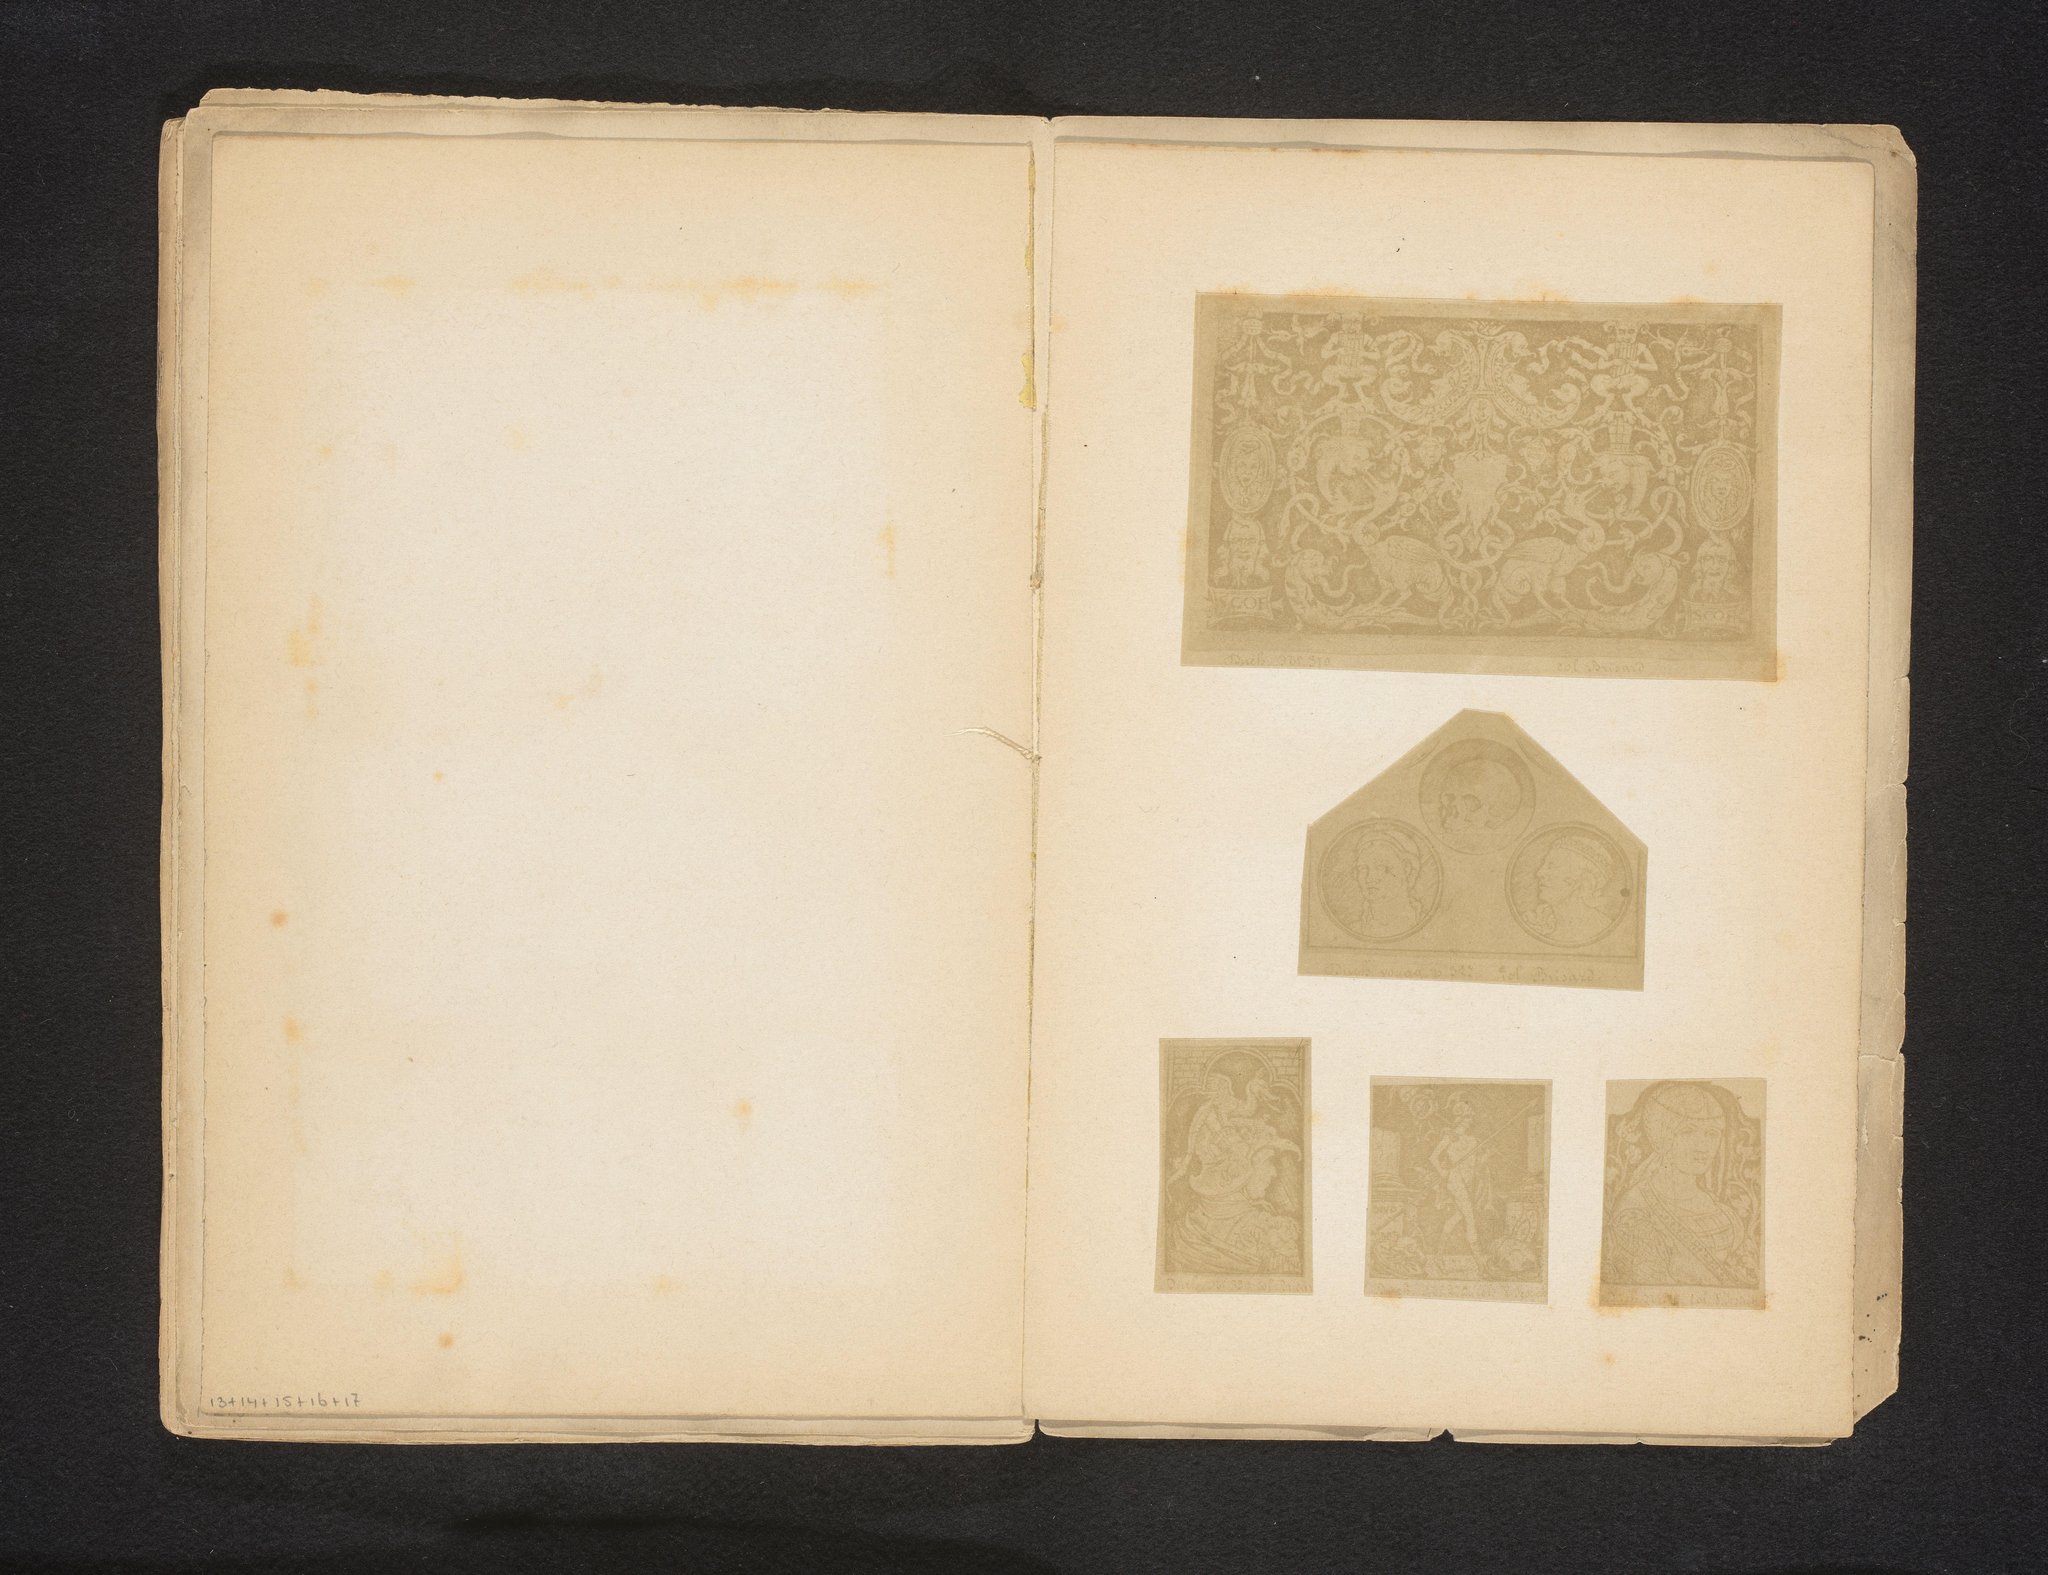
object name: page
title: Fotoreproductie van drie tekeningen, afgebeeld twee gezichten en een schedel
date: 1852-1857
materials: photographic support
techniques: salted paper print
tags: face, (human) skull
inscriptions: inscription: ‘Duch. voyag. p. 327. col. Brisard’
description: Foto op blad met vijf foto's op zevende ongenummerde pagina na pagina 60.